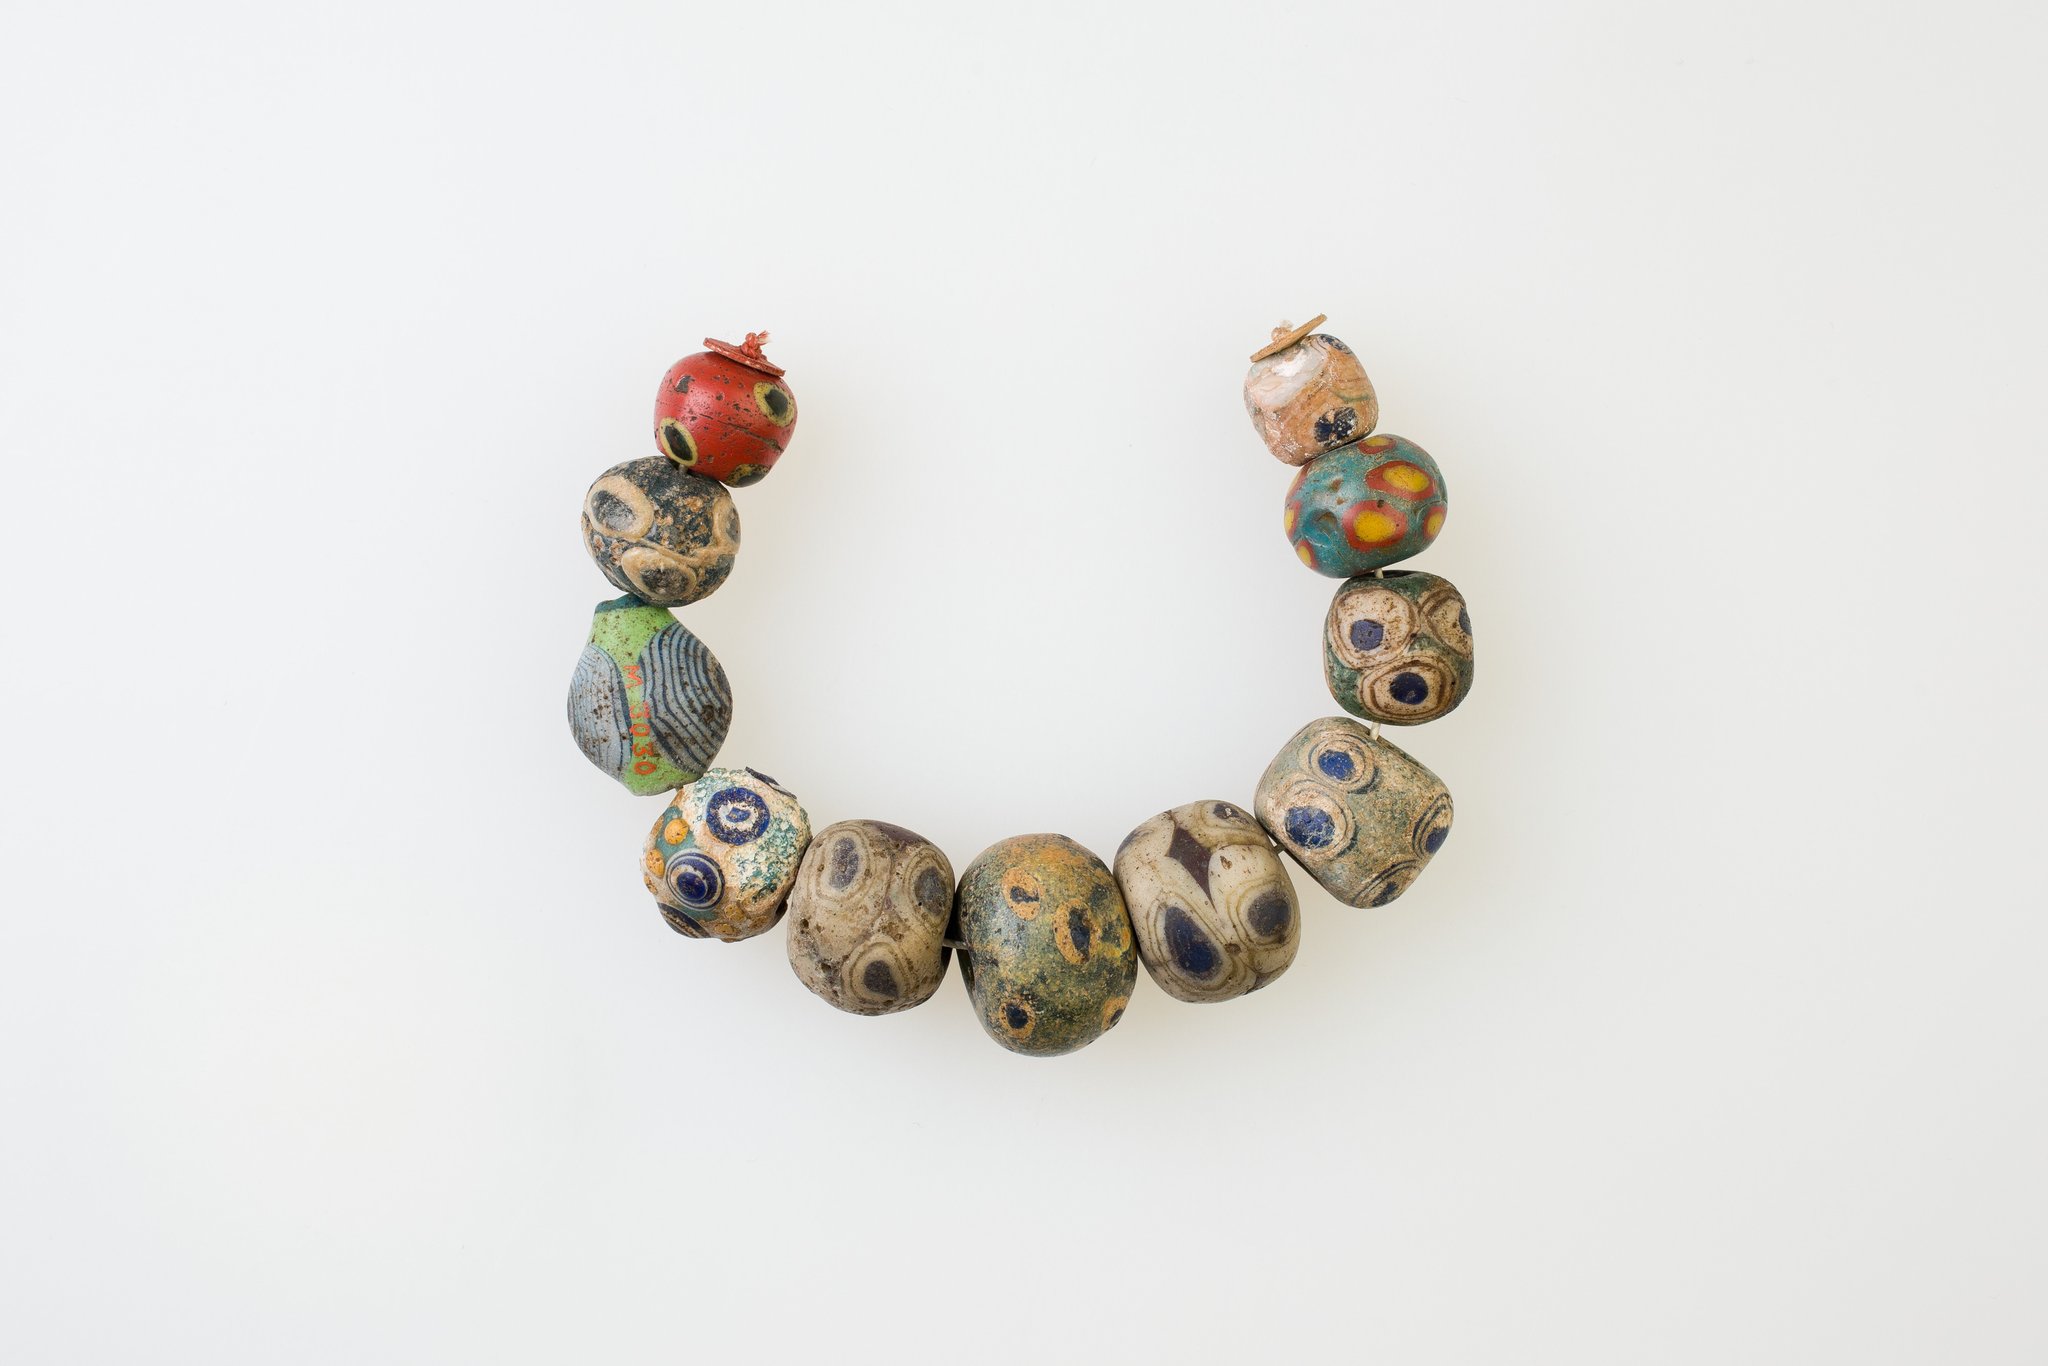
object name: necklace, bead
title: String of 11 Eye Beads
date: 600-201 BCE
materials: glass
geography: egypt